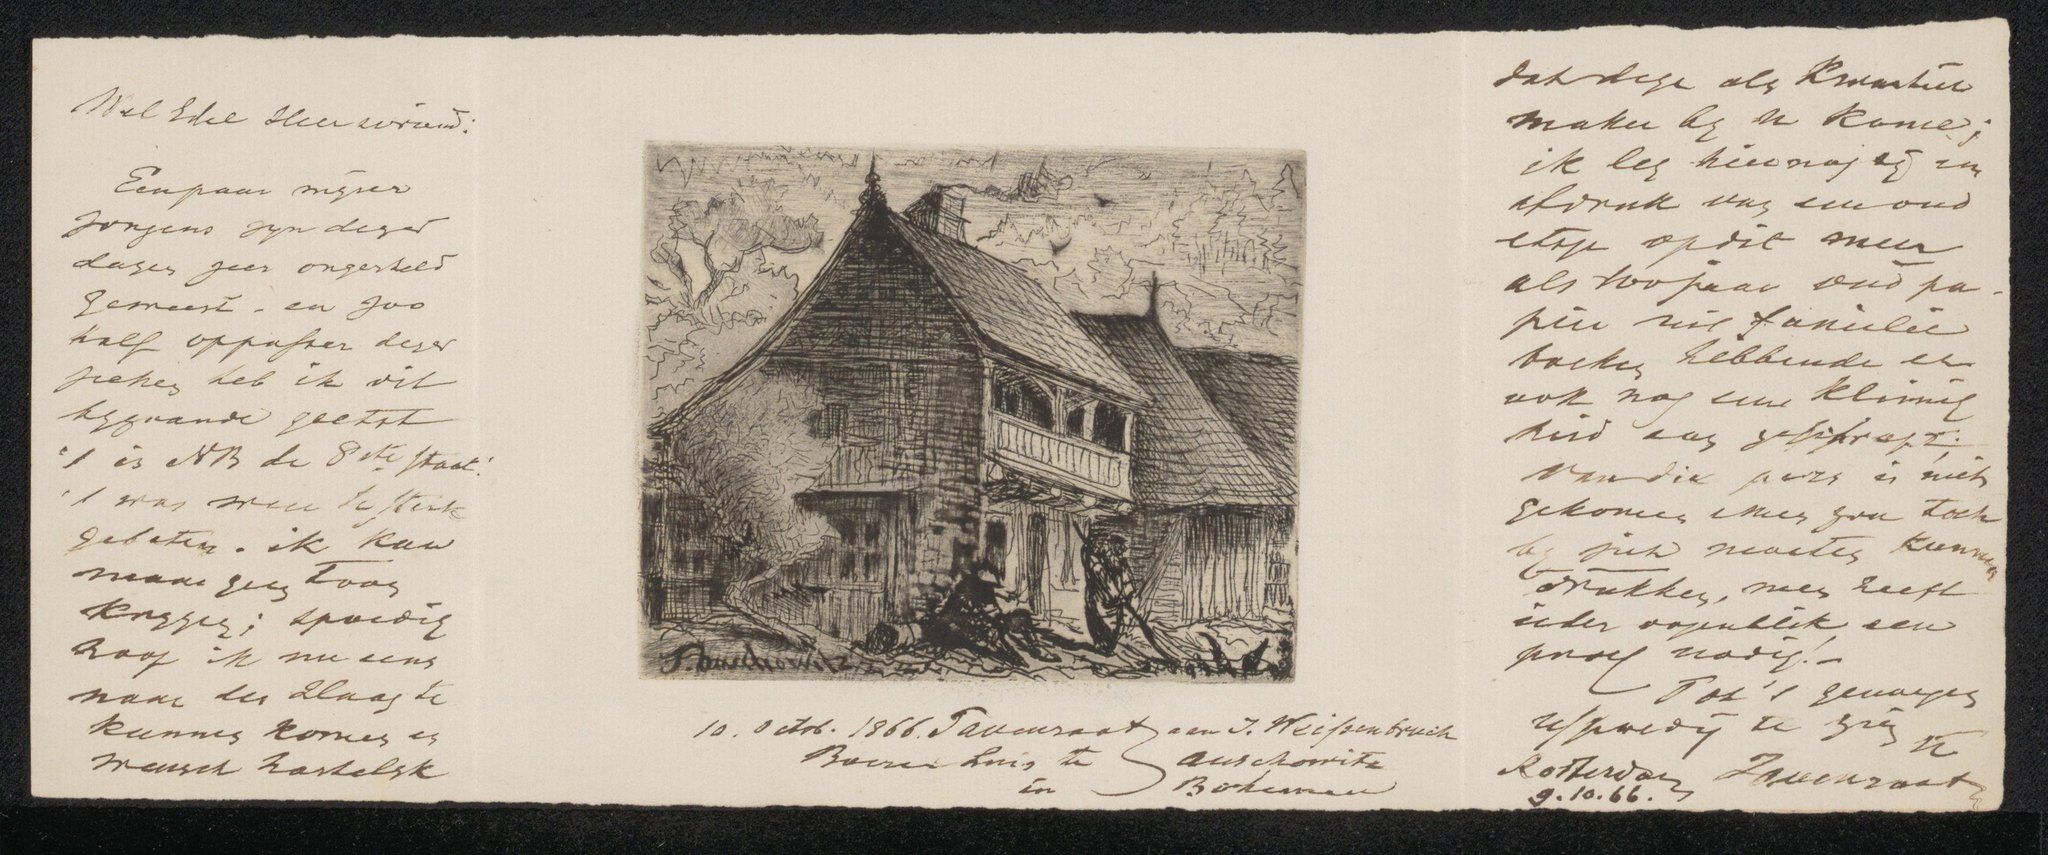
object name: letter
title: Brief aan Jan Weissenbruch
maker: johannes tavenraat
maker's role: draughtsman, painter, print maker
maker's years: 1809-1881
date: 1866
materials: ink, paper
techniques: etching, pen, writing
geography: rotterdam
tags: painter, print maker, jan weissenbruch, the graphic arts, family life, diseases, farm (building), the hague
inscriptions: collector's mark: ‘RPK’